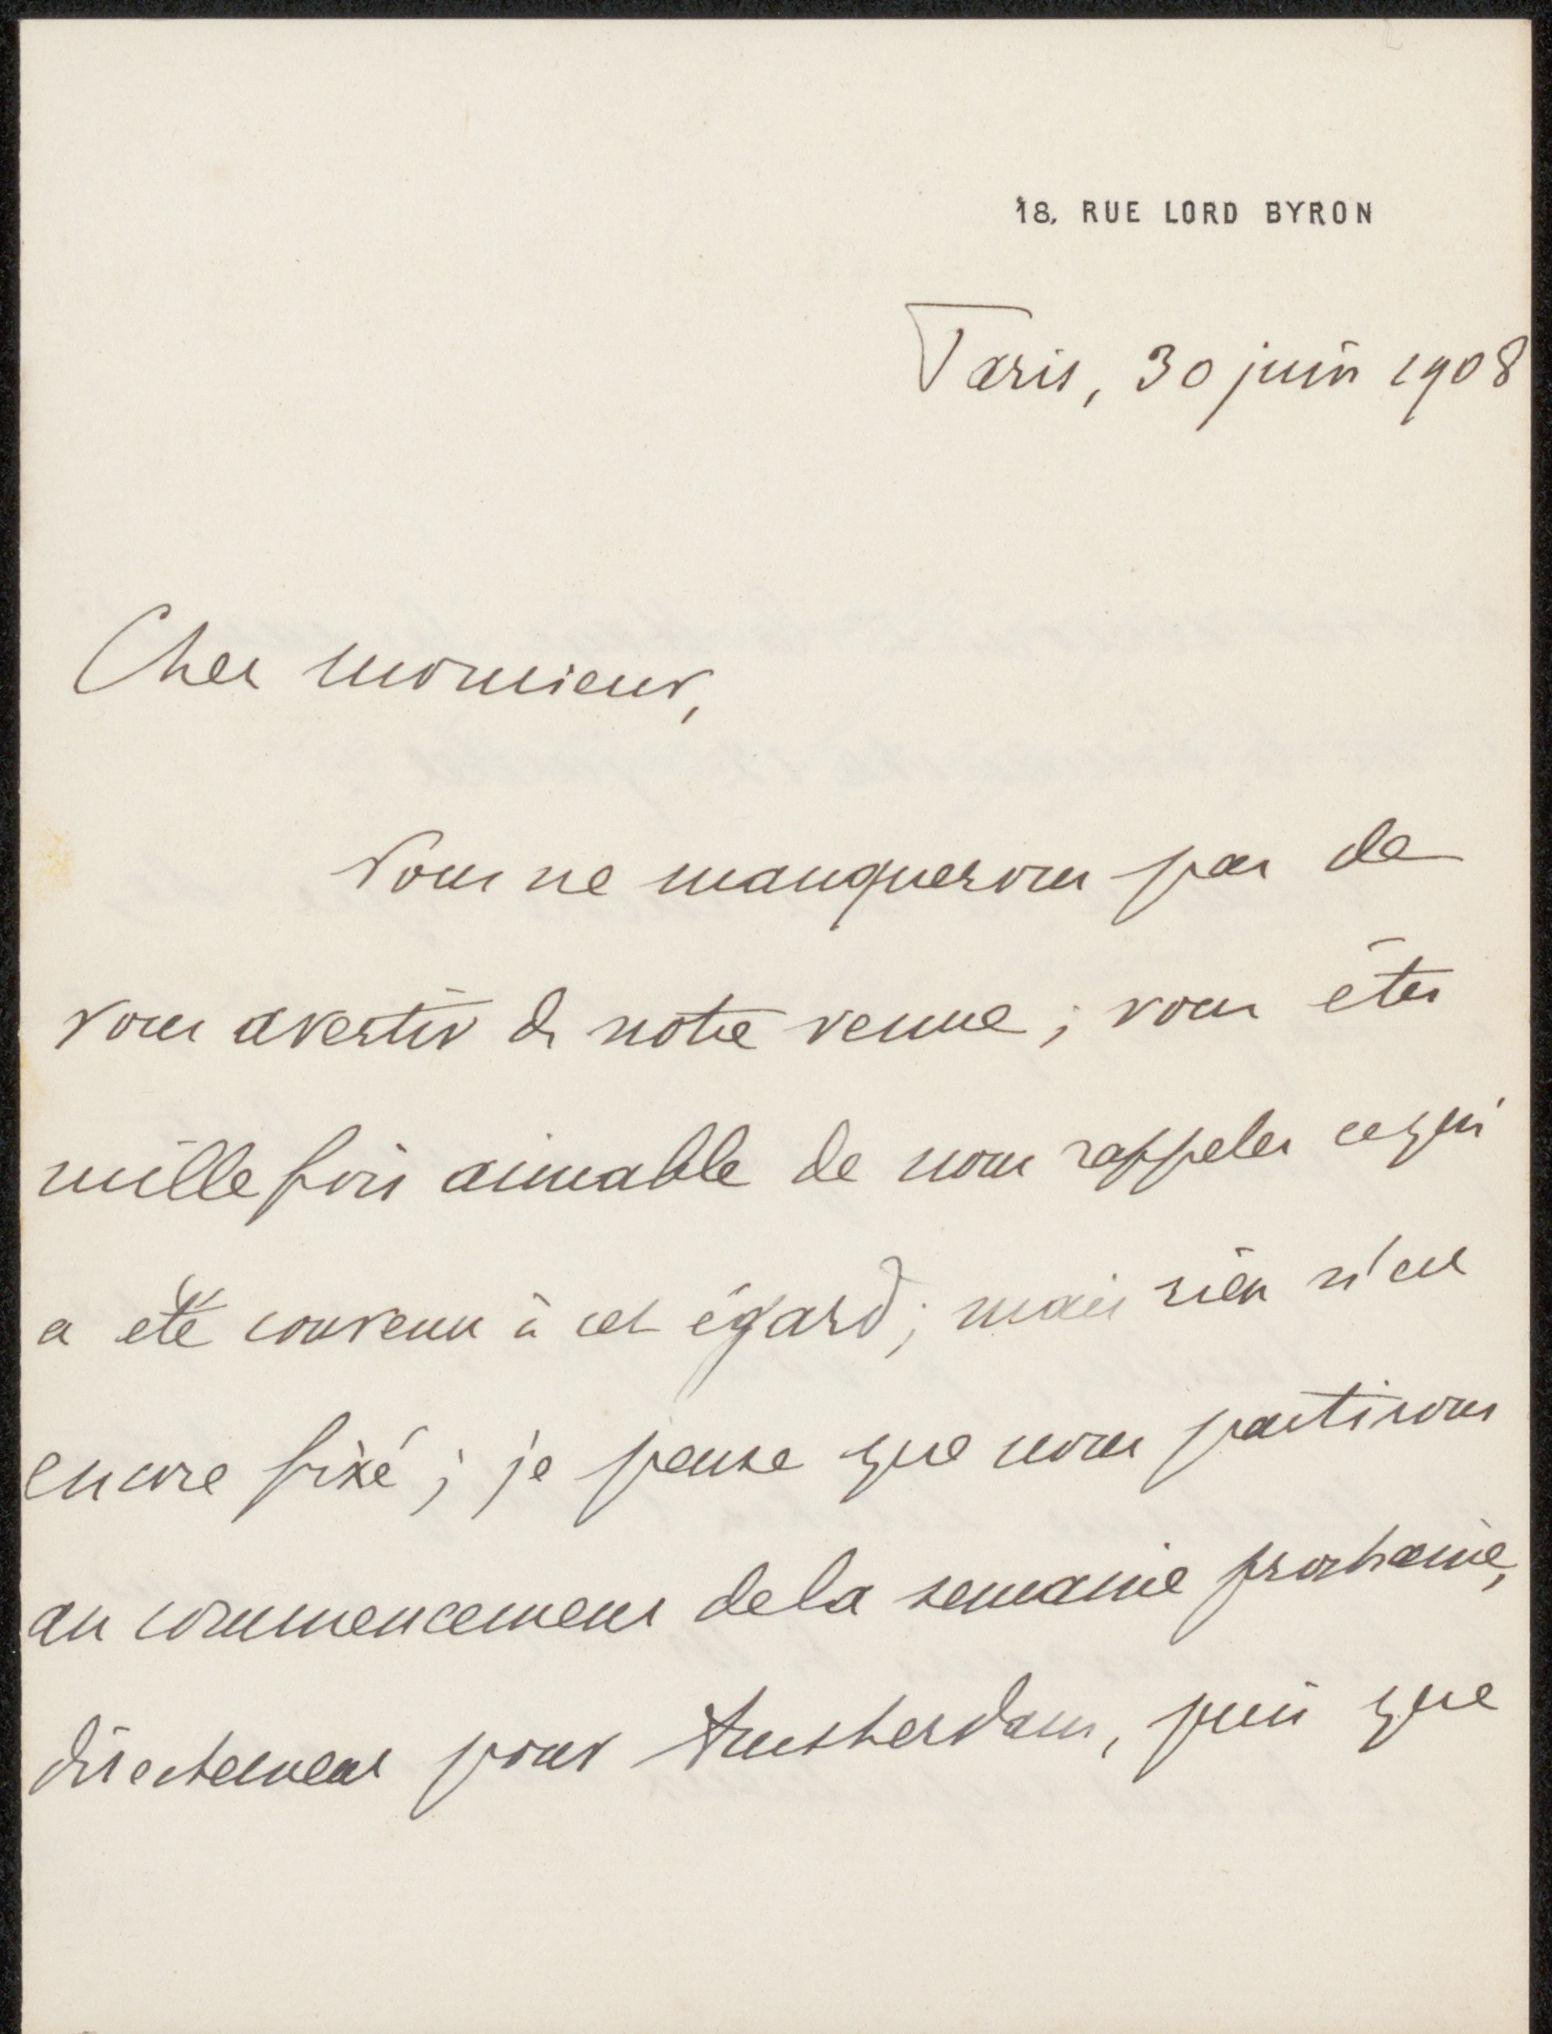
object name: letter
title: Brief aan Philip Zilcken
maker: jules comte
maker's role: official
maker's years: 1846-1912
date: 1908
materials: ink, paper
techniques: pen, printing, writing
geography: paris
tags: painter, draughtsman, philip zilcken, the hague, amsterdam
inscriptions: watermark, collector's mark: ‘RPK’